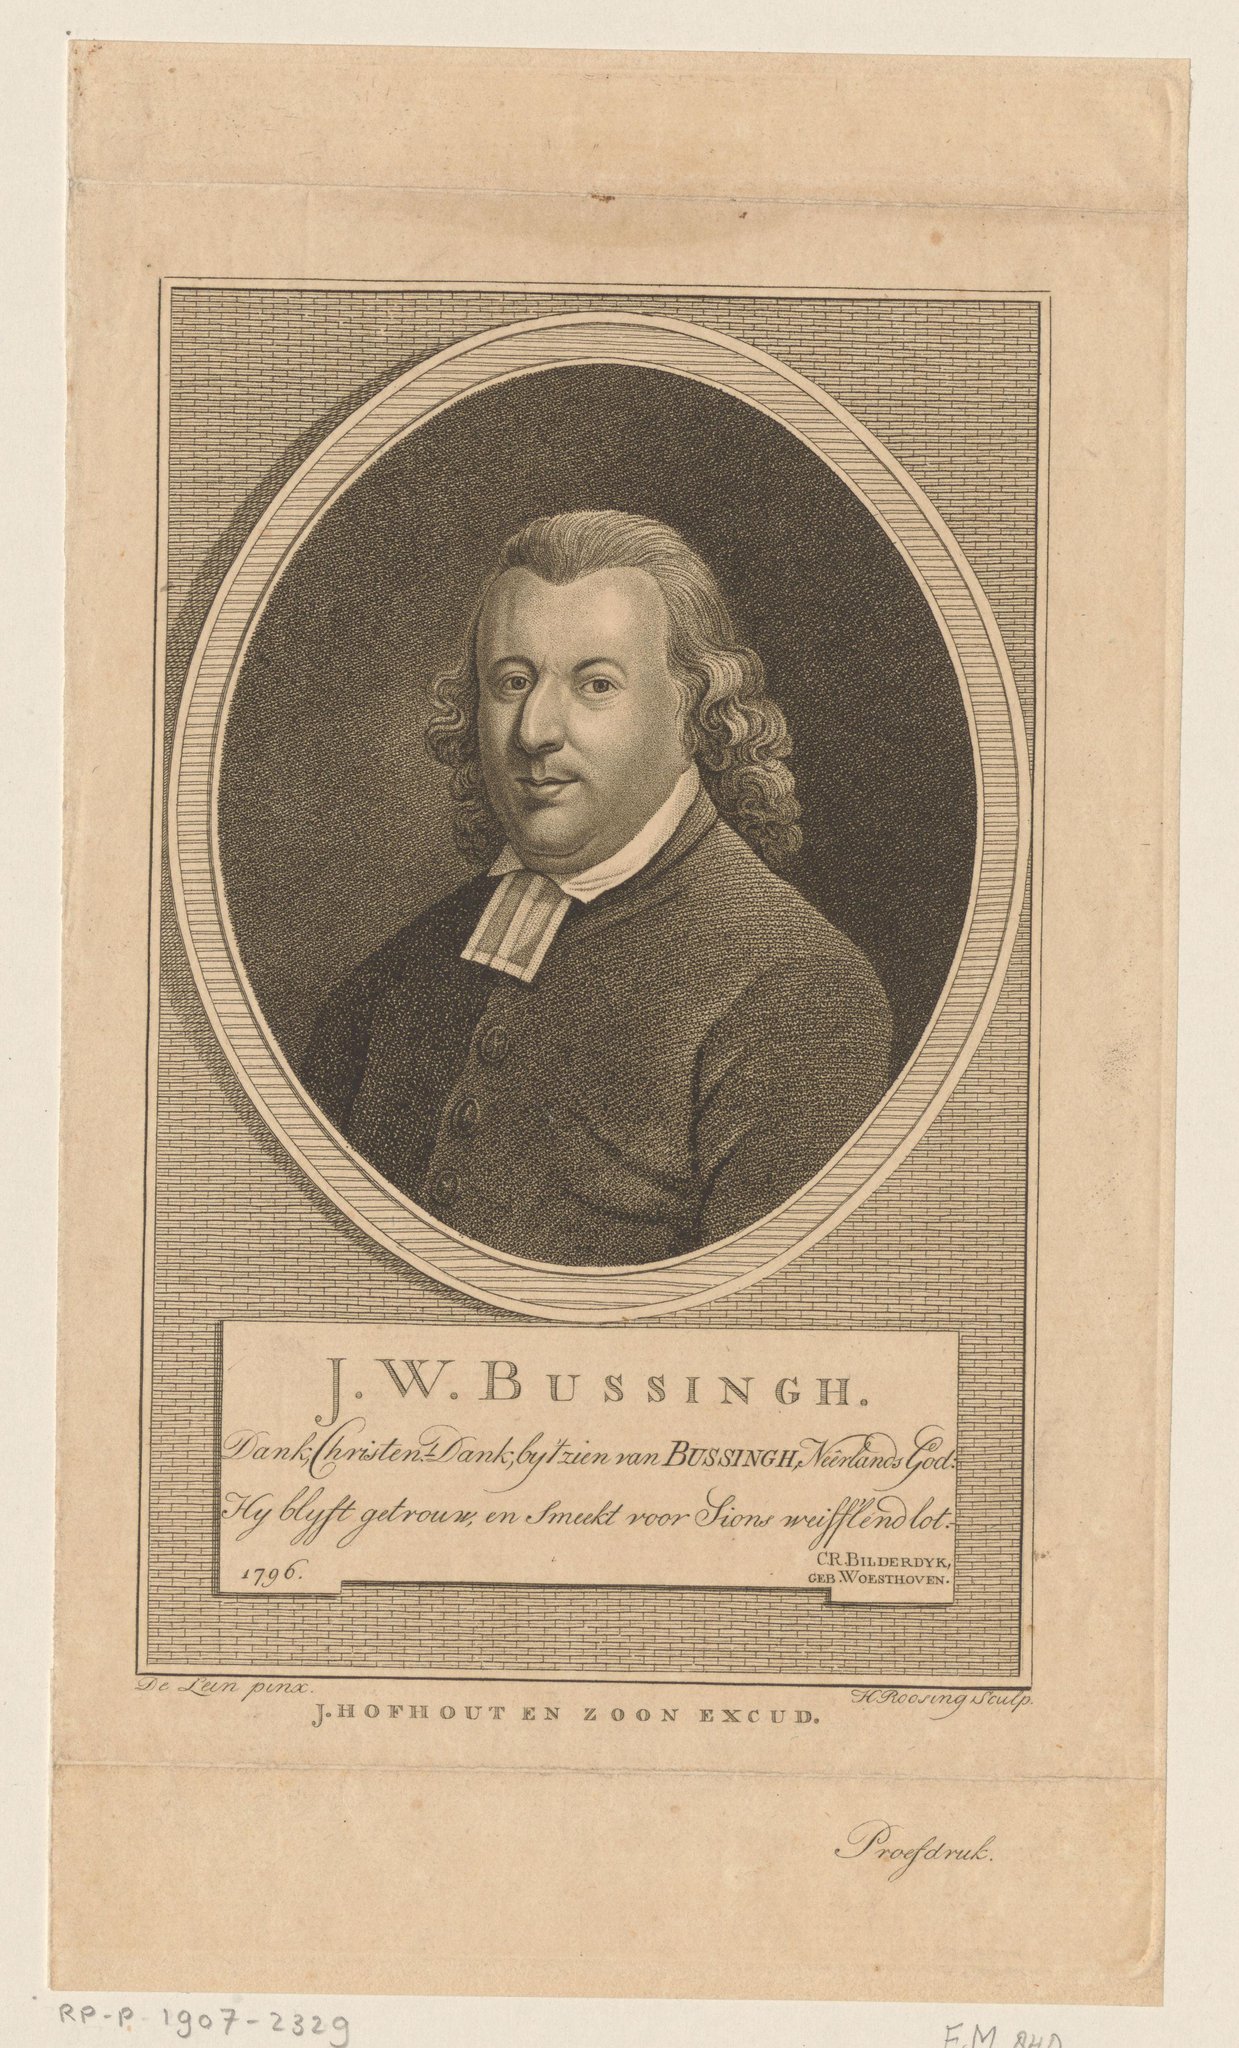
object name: print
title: Portret van Johannes Wilhelmus Bussingh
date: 1796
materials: paper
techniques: engraving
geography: rotterdam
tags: johannes wilhelmus bussingh, historical persons, portrait of a writer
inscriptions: collector's mark: Lugt 2228